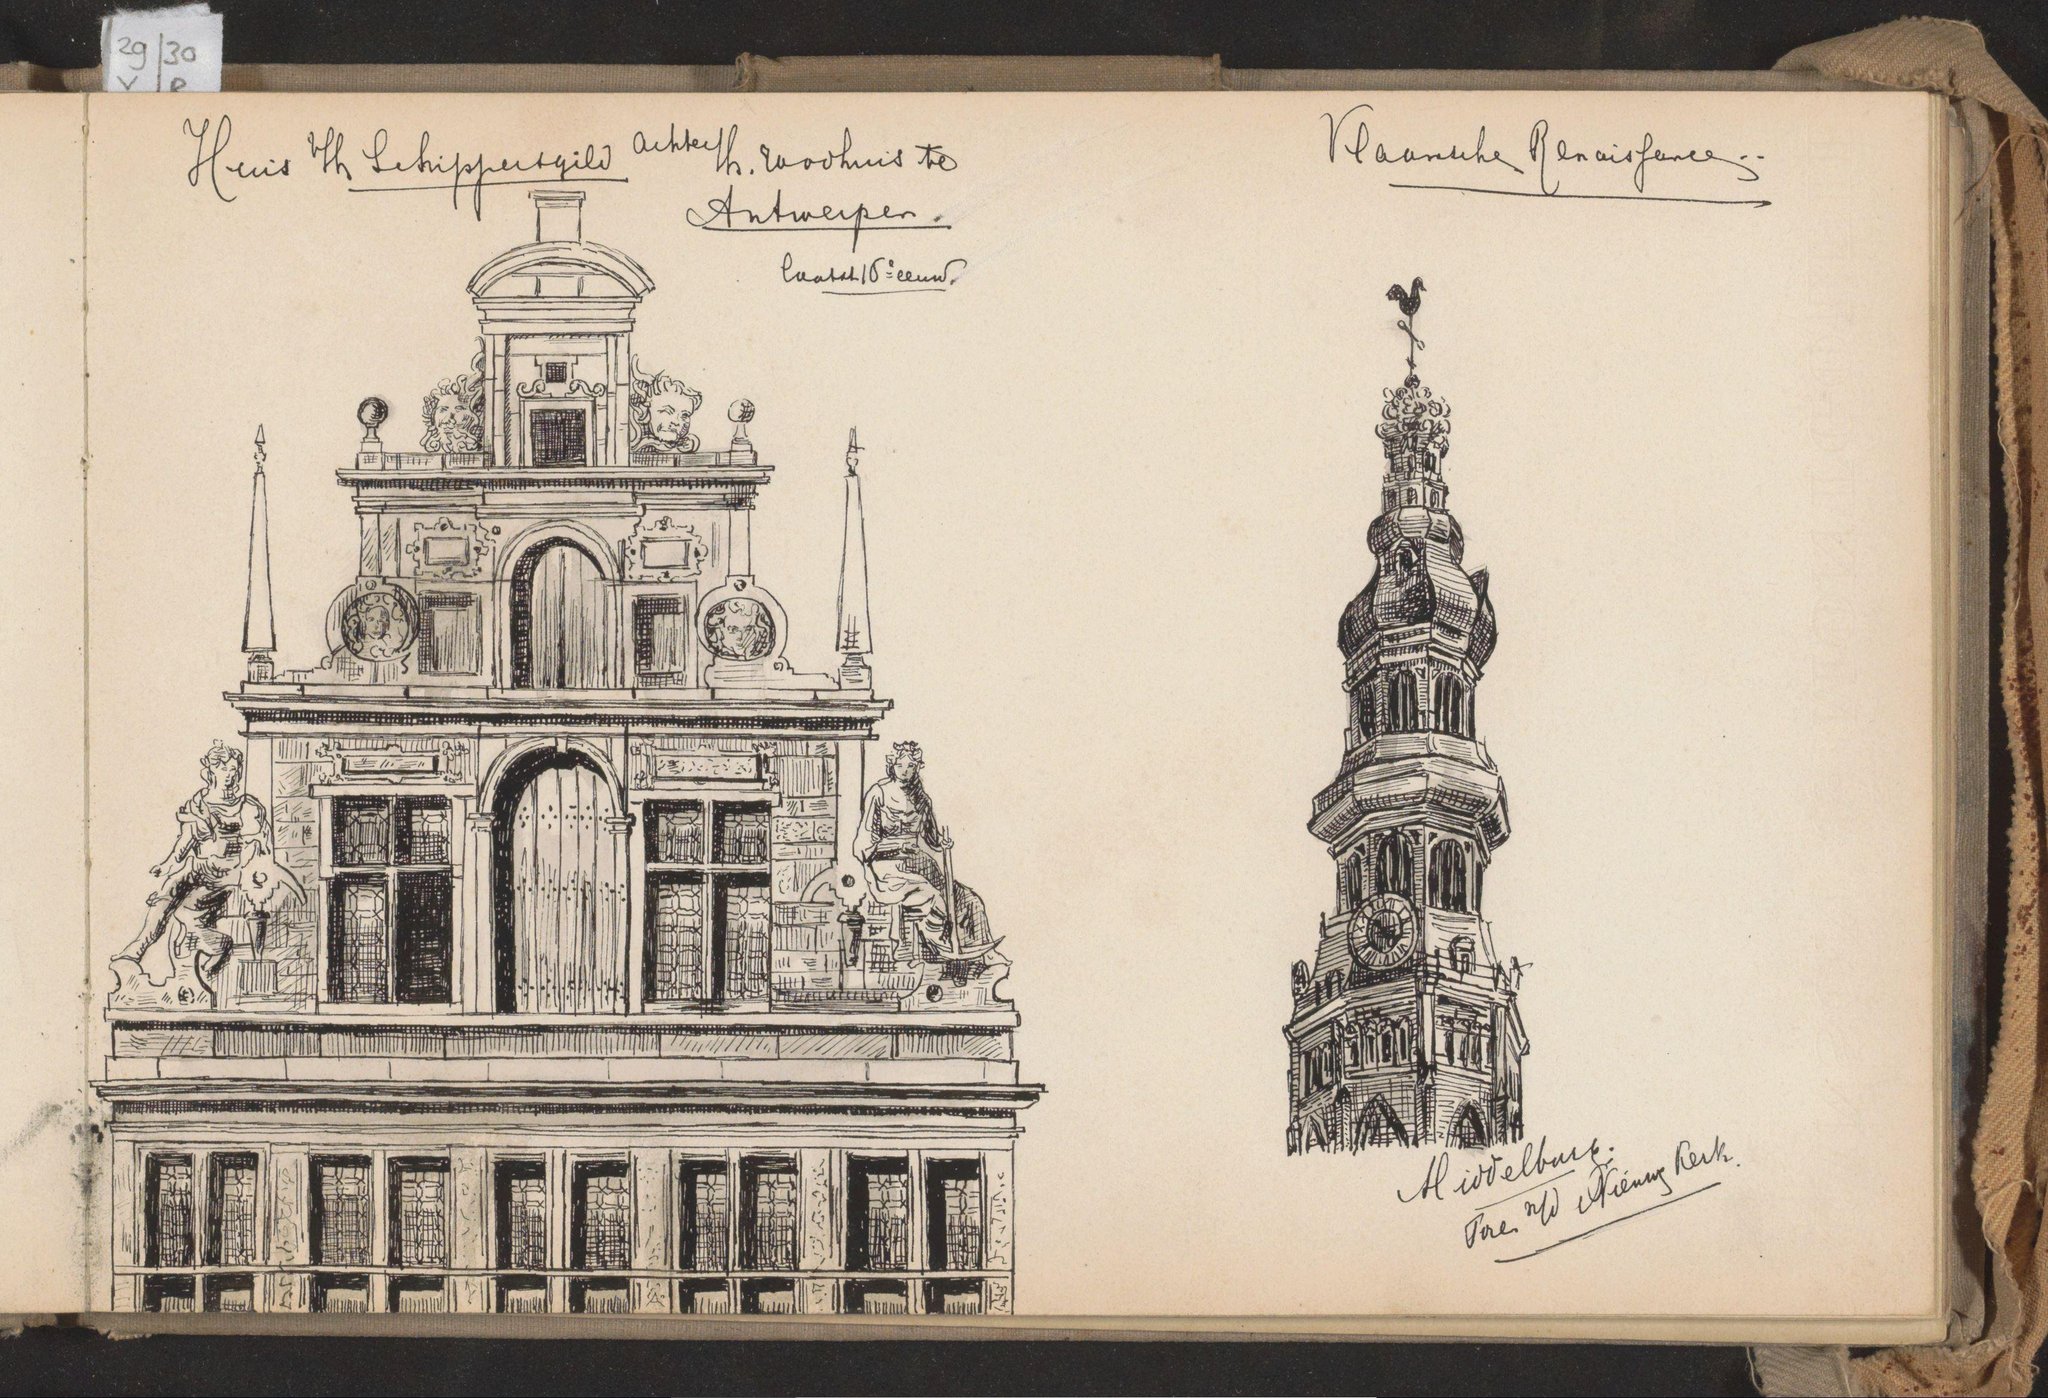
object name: sketchbook leaf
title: Façade van het huis van het Schippersgilde te Antwerpen en de toren van de Nieuwe Kerk te Middelburg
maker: johanna van de kamer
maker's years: 1873-1922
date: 1890-1922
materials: ink, paper, pencil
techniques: brush, pen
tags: exterior ~ representation of a building, parts of church exterior and annexes: tower, antwerp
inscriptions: annotation: ‘Huis vh Schippersgild achter h raadhuis te/ Antwerpen/ laat[...]16=eeuw/ Vlaamsche Renaissance/ Middelburg/ Toren v/d Nieuwe Kerk’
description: Blad 28 recto uit een schetsboek met 49 bladen.